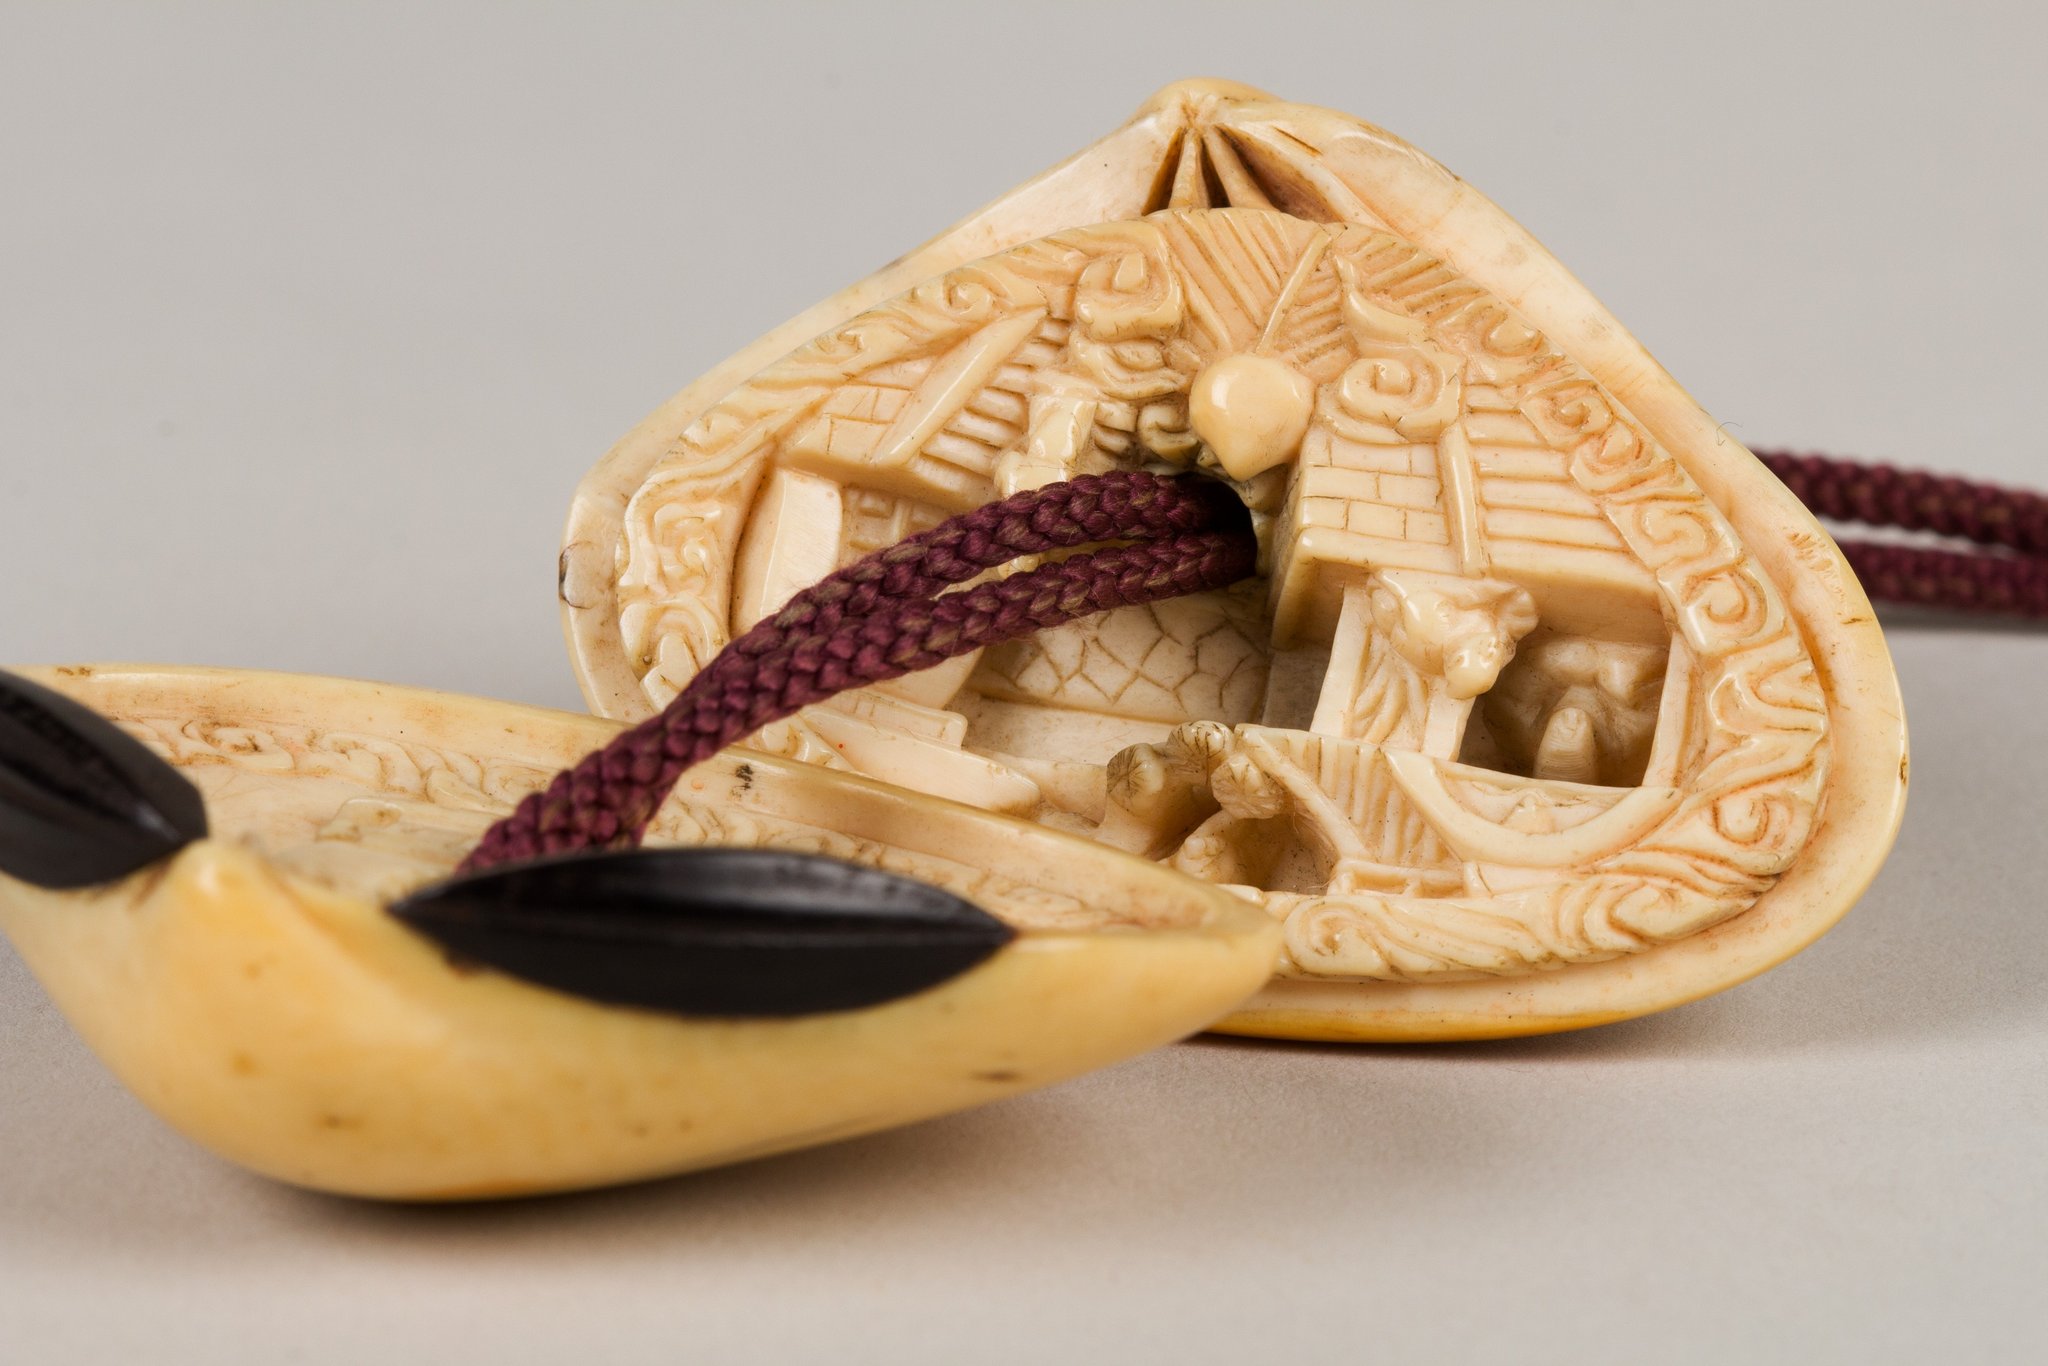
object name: netsuke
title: Netsuke in the form of a Clamshell Containing a Landscape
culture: japanese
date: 1801-1900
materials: ivory